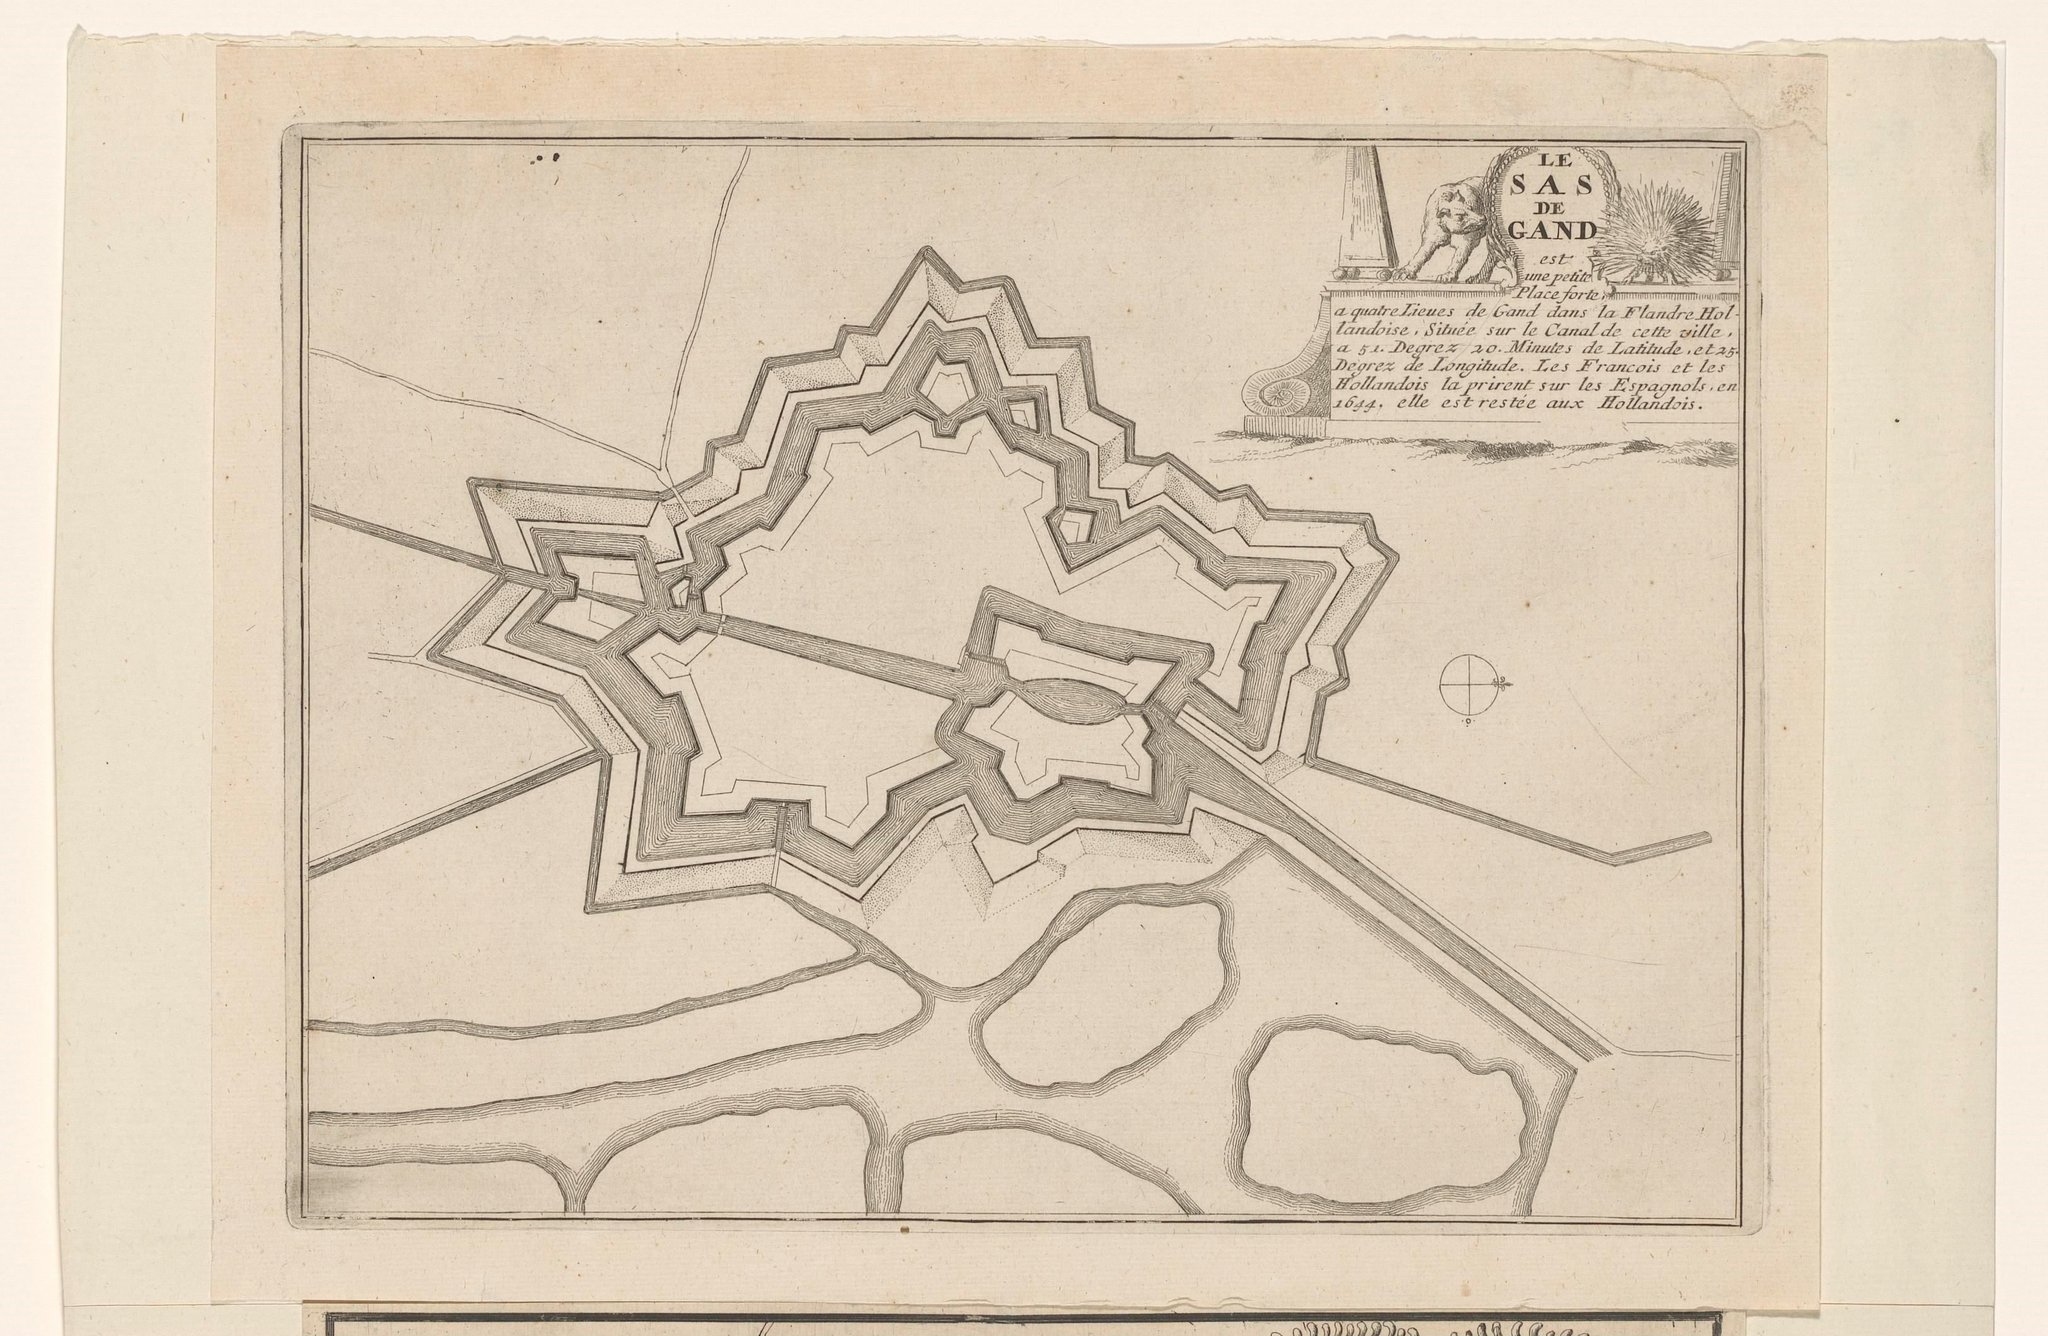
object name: print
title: Vestingplattegrond van Sas van Gent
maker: Anonymous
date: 1690-1700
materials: paper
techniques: engraving, etching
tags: fortified city, maps of cities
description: Prent ook gebruikt in: Fer, Nicolas de. Les forces de l'Europe, ou description des principales villes, avec leurs fortifications : dessignées par les meilleurs ingenieurs, particulierement celles (…). Parijs: Nicolas de Fer, 1690-1695. En in: Las Fuerzas de la Europa, o la descripcion de las principales ciudades (…). Amsterdam: George Gallet, 1700.